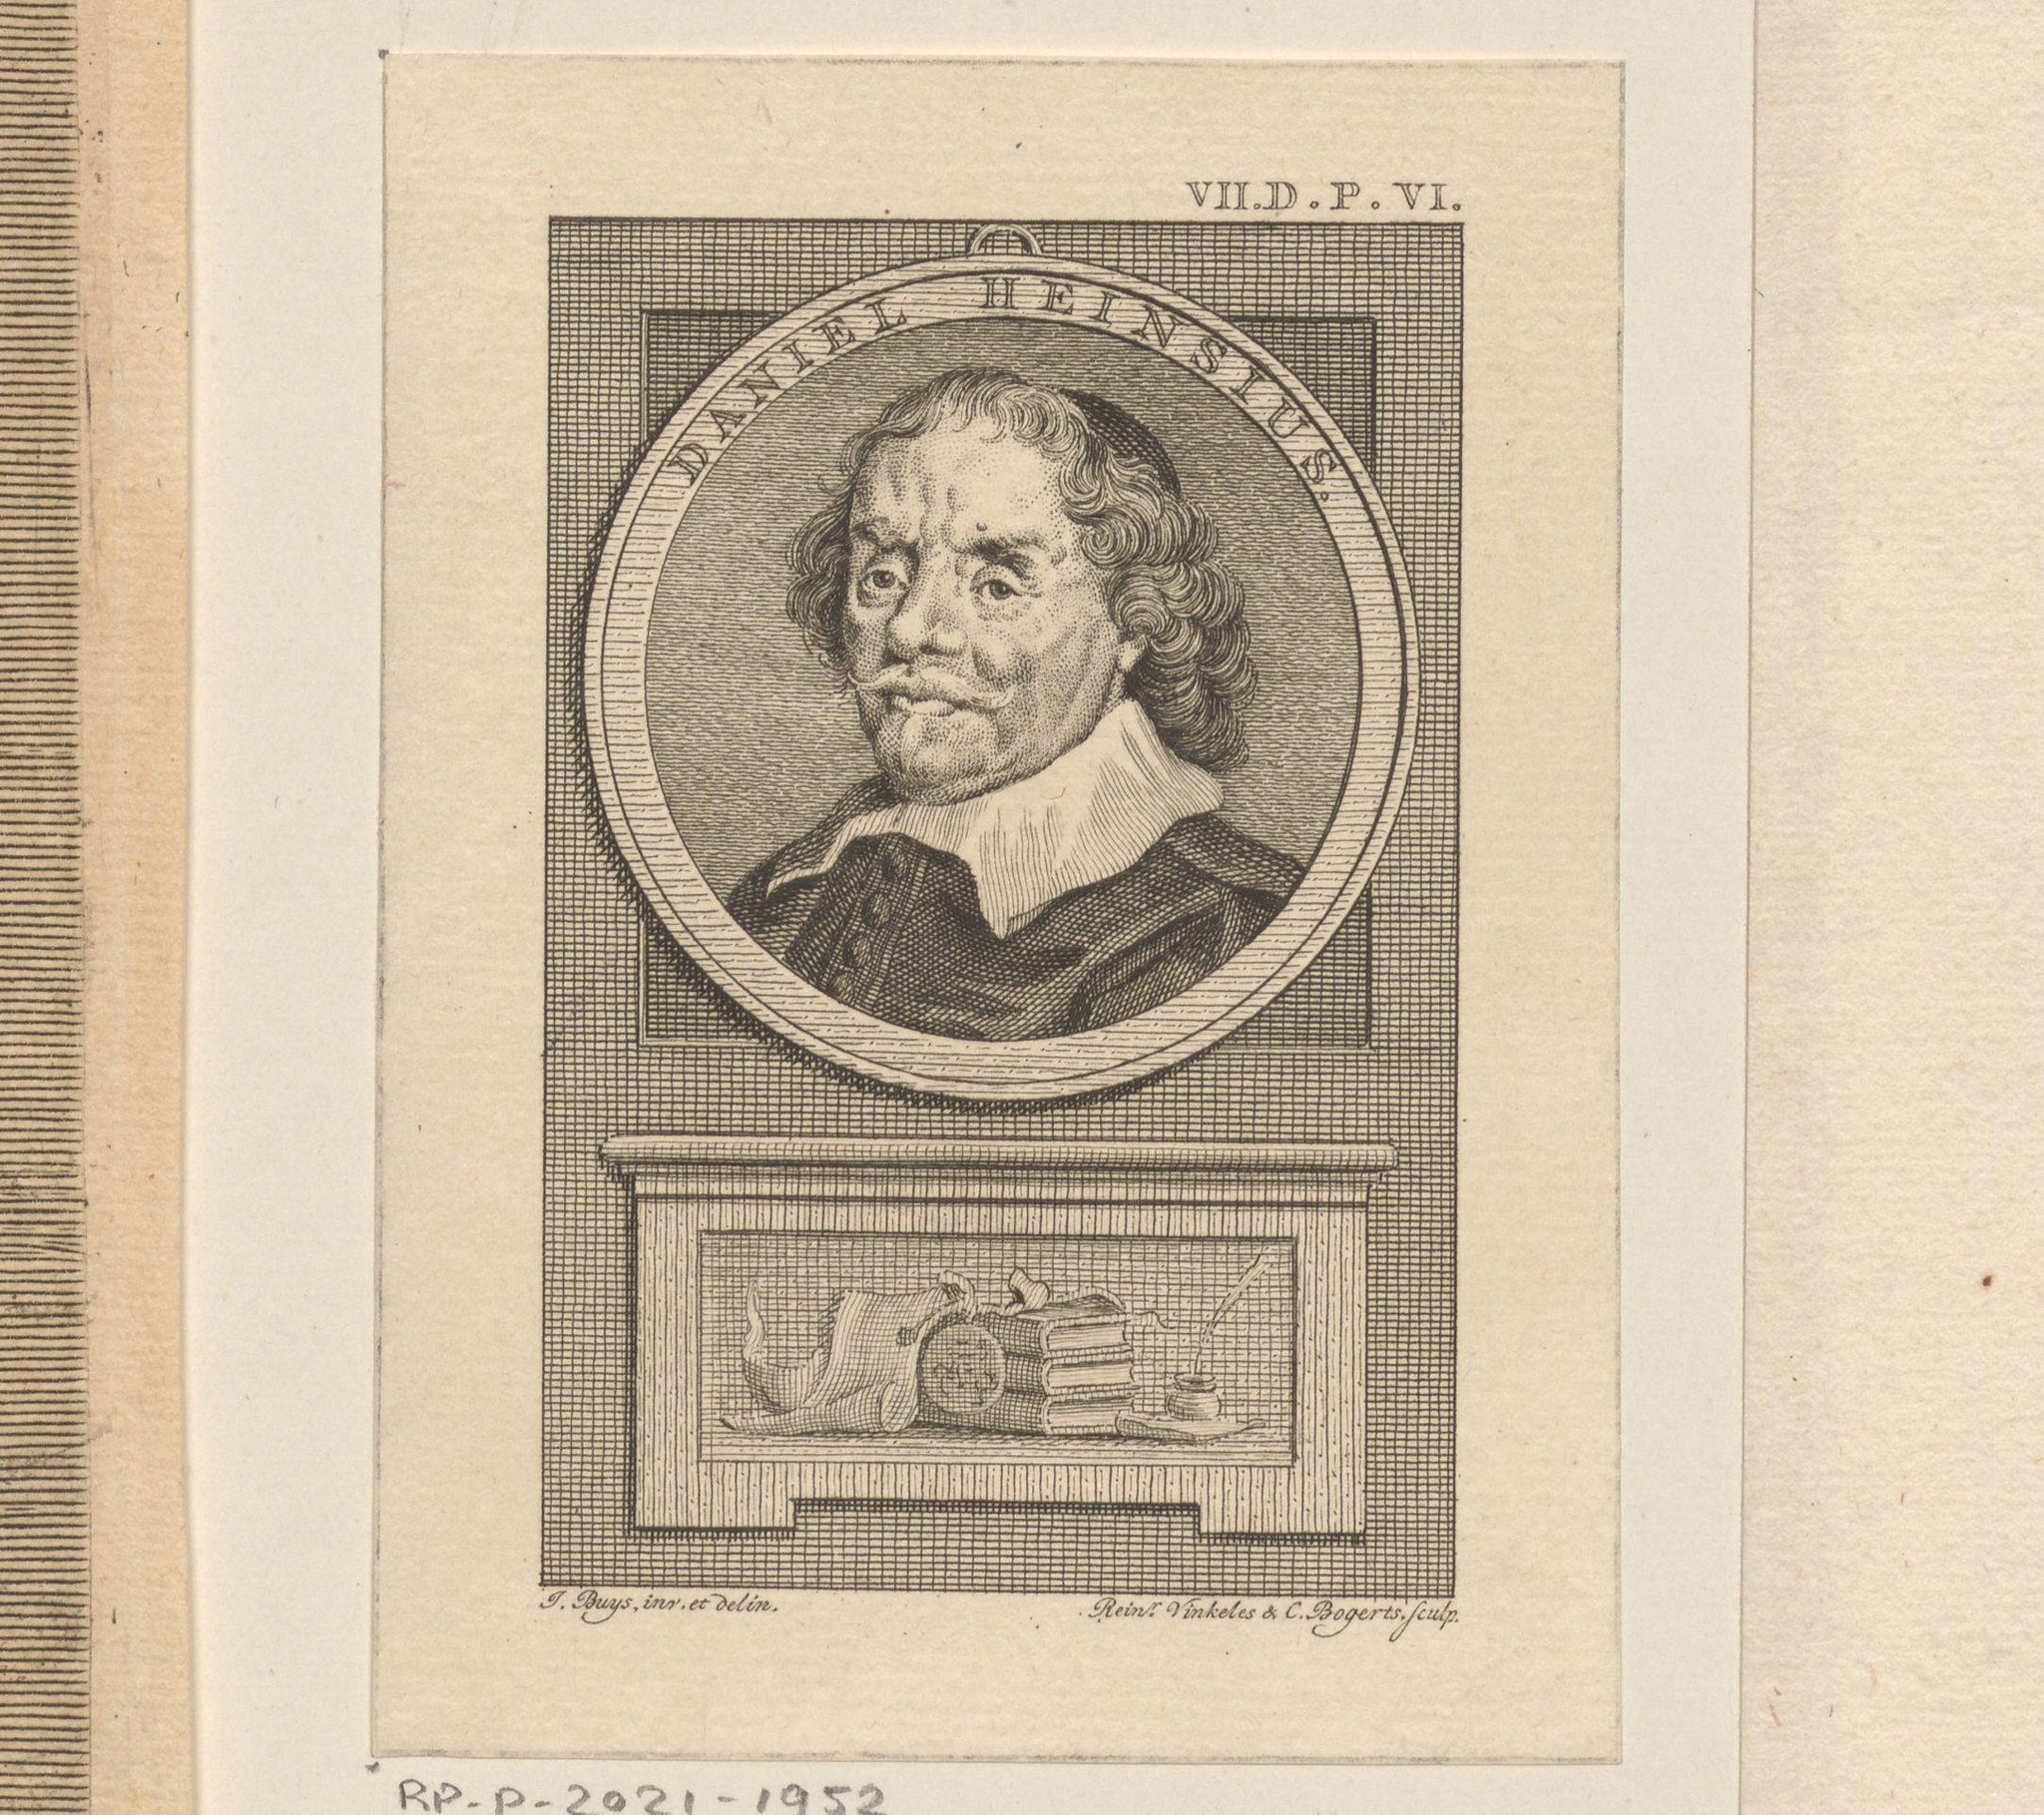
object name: book illustration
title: Portret van Daniël Heinsius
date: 1783-1795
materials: paper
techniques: engraving, etching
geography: amsterdam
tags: ghent, leiden, daniël heinsius, scholar, philosopher, historical persons, portrait of a writer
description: Prent uit: Fokke, Jan. Geschiedenissen der Vereenigde Nederlanden voor de vaderlandsche jeugd (...). Amsterdam: Johannes Allart, 1783-1795, dl. 7.